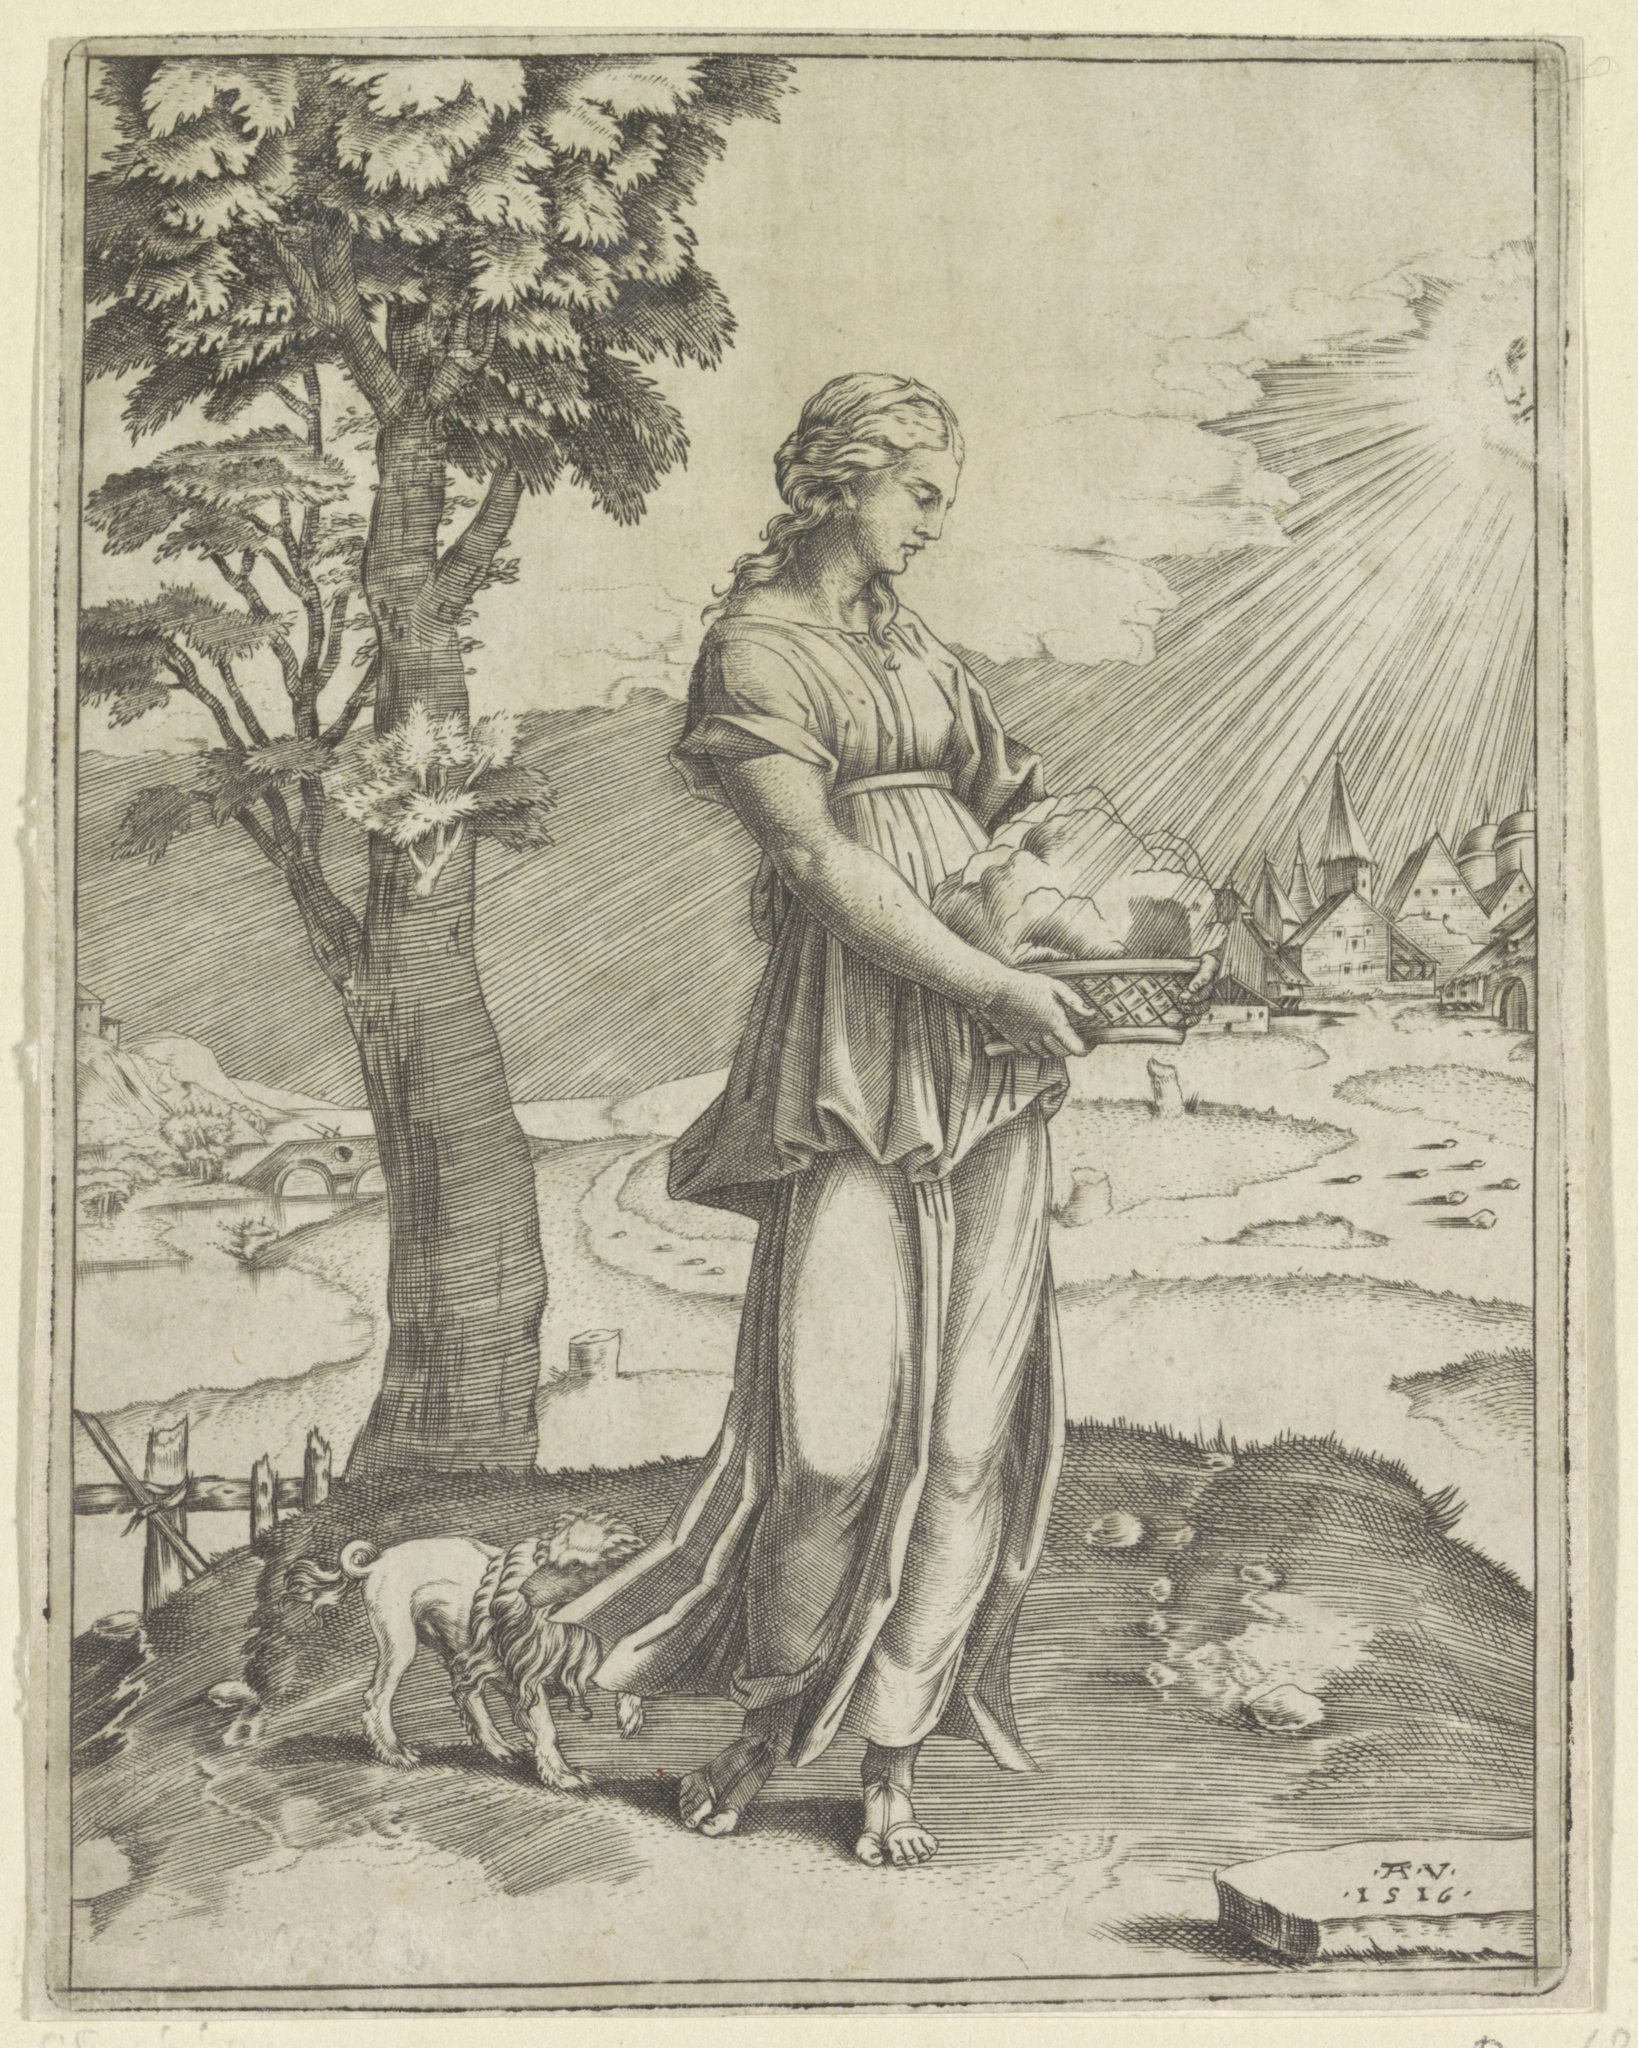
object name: print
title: Sibille van Cumae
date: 1516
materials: paper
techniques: engraving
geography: italy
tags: carrying something in basket, bag, rucksack, etc., the cumaean sibyl is granted long life: apollo grants the cumaean sibyl as many years as she has grains of sand in her hand, in return for her love (ovid, metamorphoses xiv 136), cumaean sibyl, dog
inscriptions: collector's mark: Lugt 240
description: De Sibille van Cumae staat in een landschap met een mand vol zand in haar handen. Apollo schonk haar voor elke zandkorrel een levensjaar. Links naast haar staat een hond. Op de achtergrond een dorp aan een rivier.